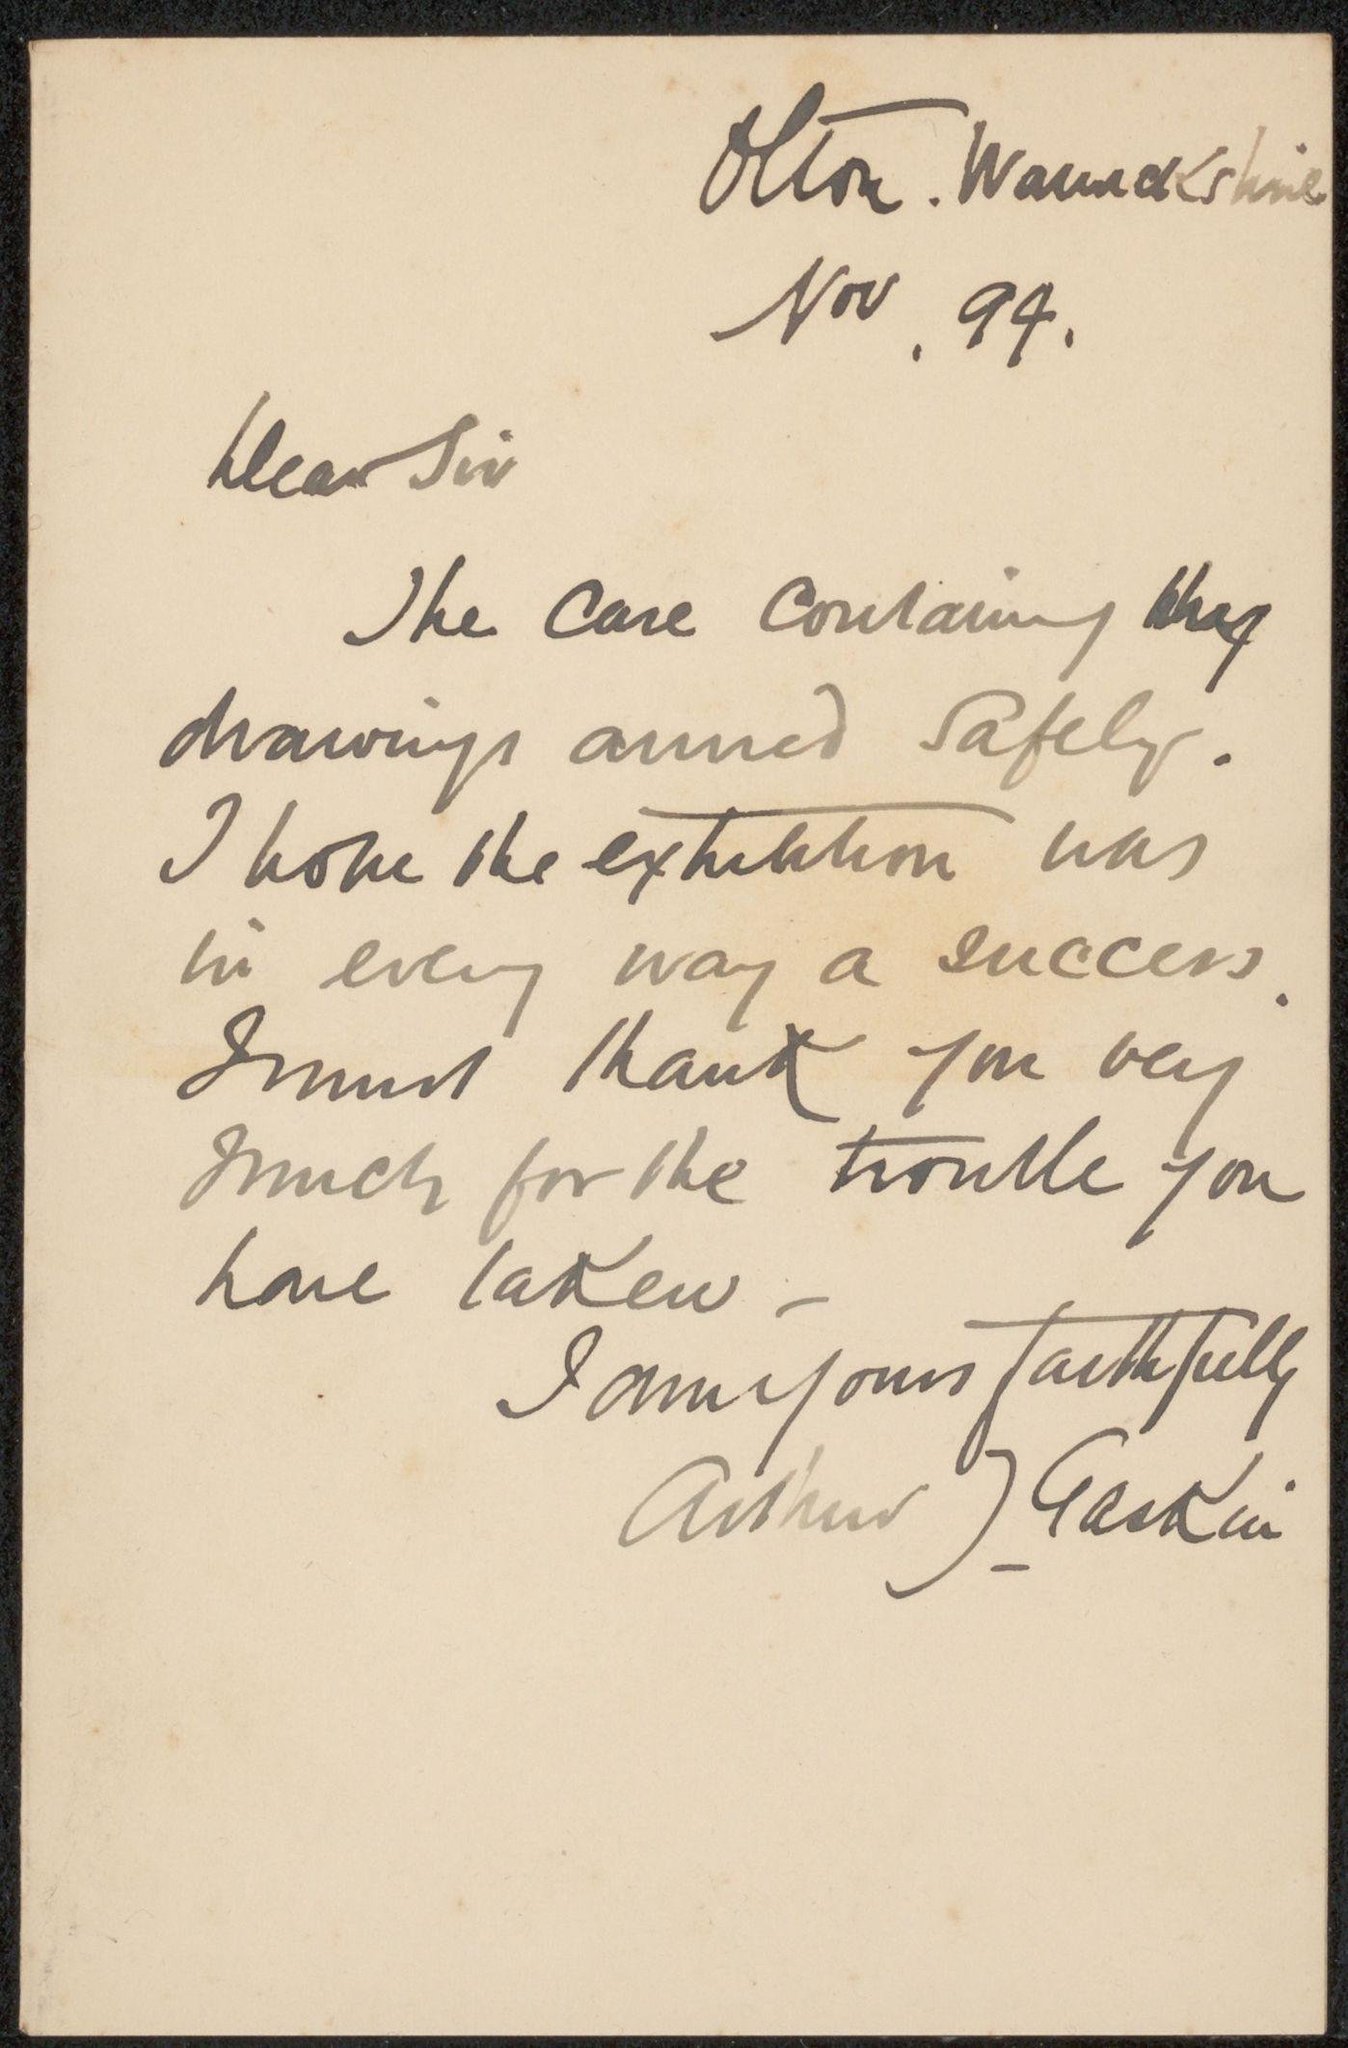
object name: letter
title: Brief aan Philip Zilcken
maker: arthur gaskin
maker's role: painter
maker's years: 1862-1928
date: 1811-1894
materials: ink, paper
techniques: pen, writing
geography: warwickshire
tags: painter, draughtsman, philip zilcken, drawing, sending and receiving postal matter, temporary exhibition, 'salon'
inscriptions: watermark, collector's mark: ‘RPK’